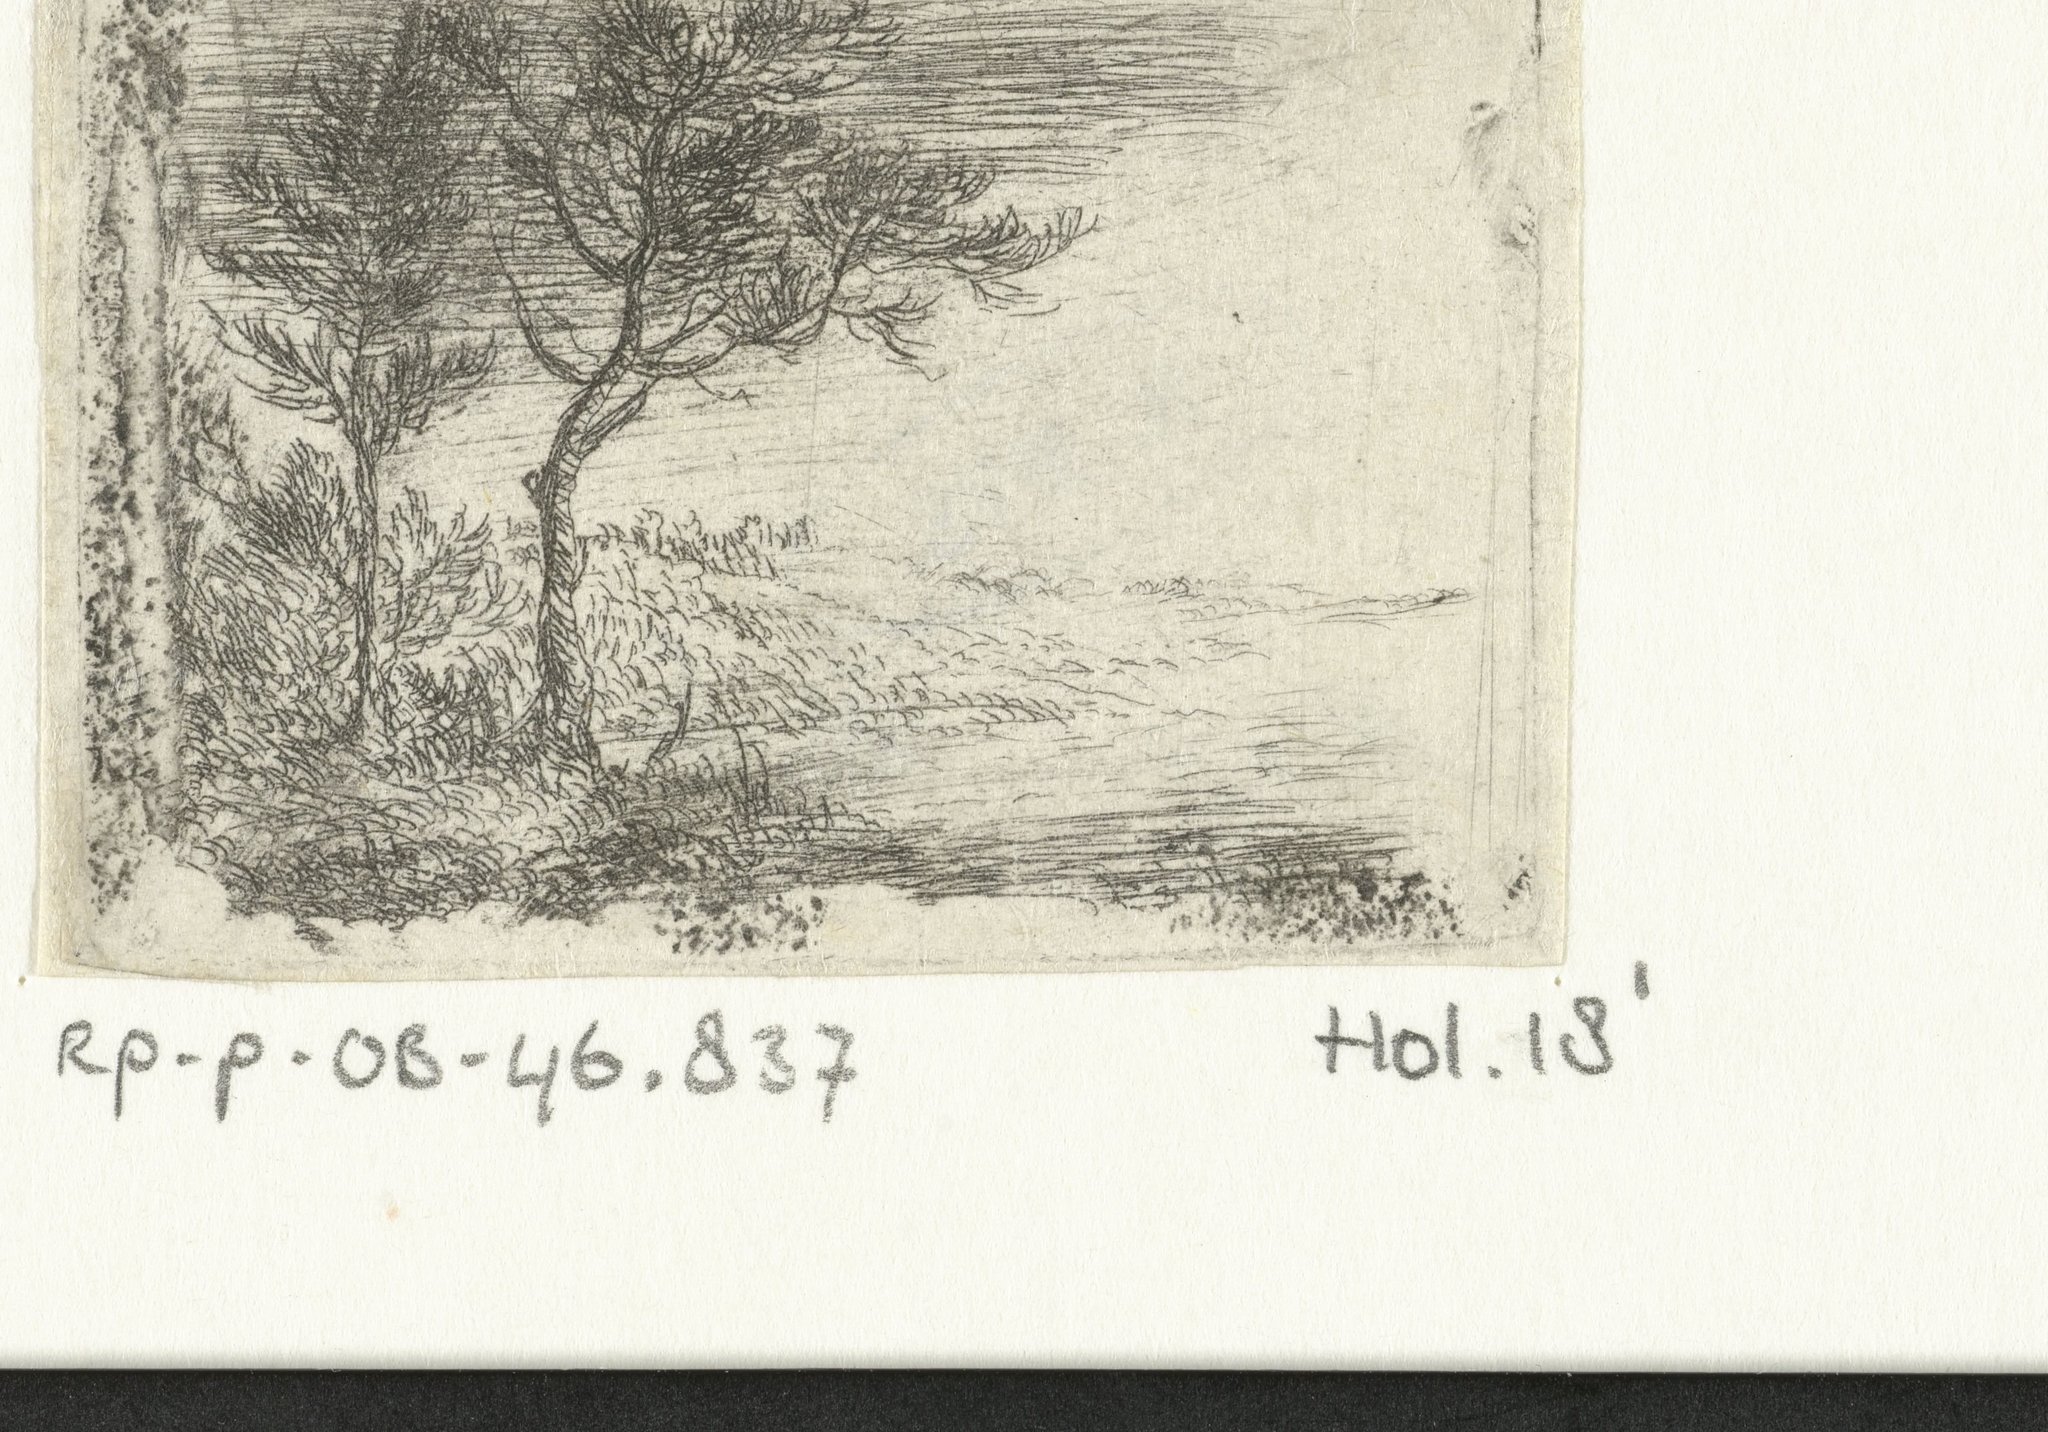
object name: print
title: Landschap twee bomen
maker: pieter bodding van laer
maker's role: draughtsman, painter, print maker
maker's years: 1599-1642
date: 1609-1642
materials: paper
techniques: etching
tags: trees, landscapes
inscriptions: collector's mark: Lugt 2228